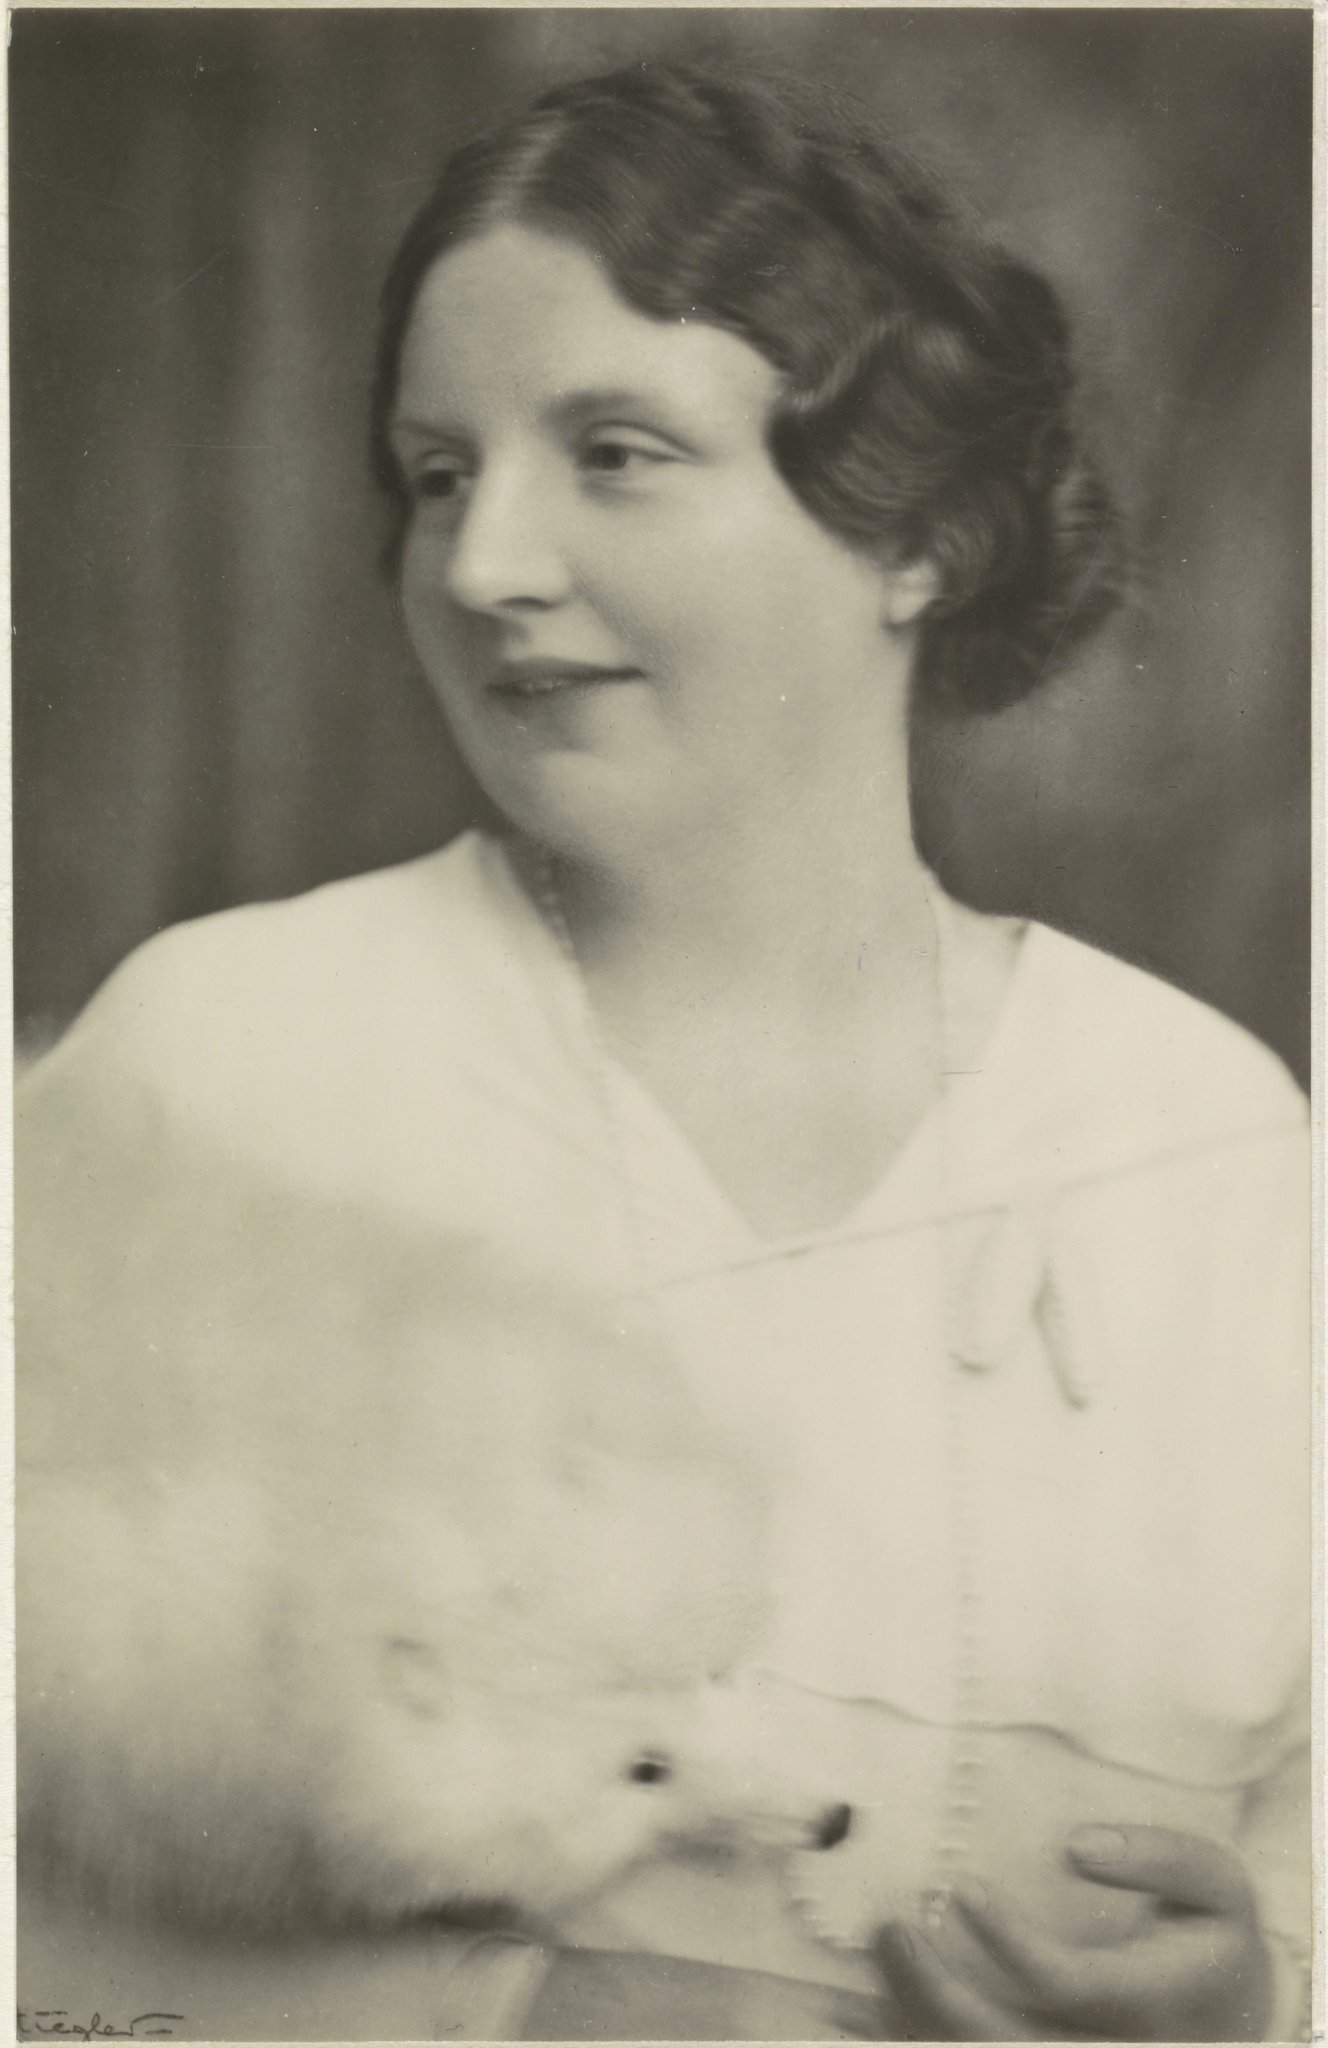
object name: ansichtkaart, prentbriefkaart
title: Portret van Juliana, koningin der Nederlanden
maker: franz ziegler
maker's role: fotograaf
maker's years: 1893-1939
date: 1934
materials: photographic support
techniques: photography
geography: amsterdam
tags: juliana of the netherlands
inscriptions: address: ‘BOEKH. LANKAMP & BRINKMAN AMSTERDAM-C. SPIEGELGRACHT’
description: De hier vermelde titel verwijst naar de hoogst verkregen titel van de geportretteerde, niet per se naar de titel die de geportretteerde op deze voorstelling draagt.